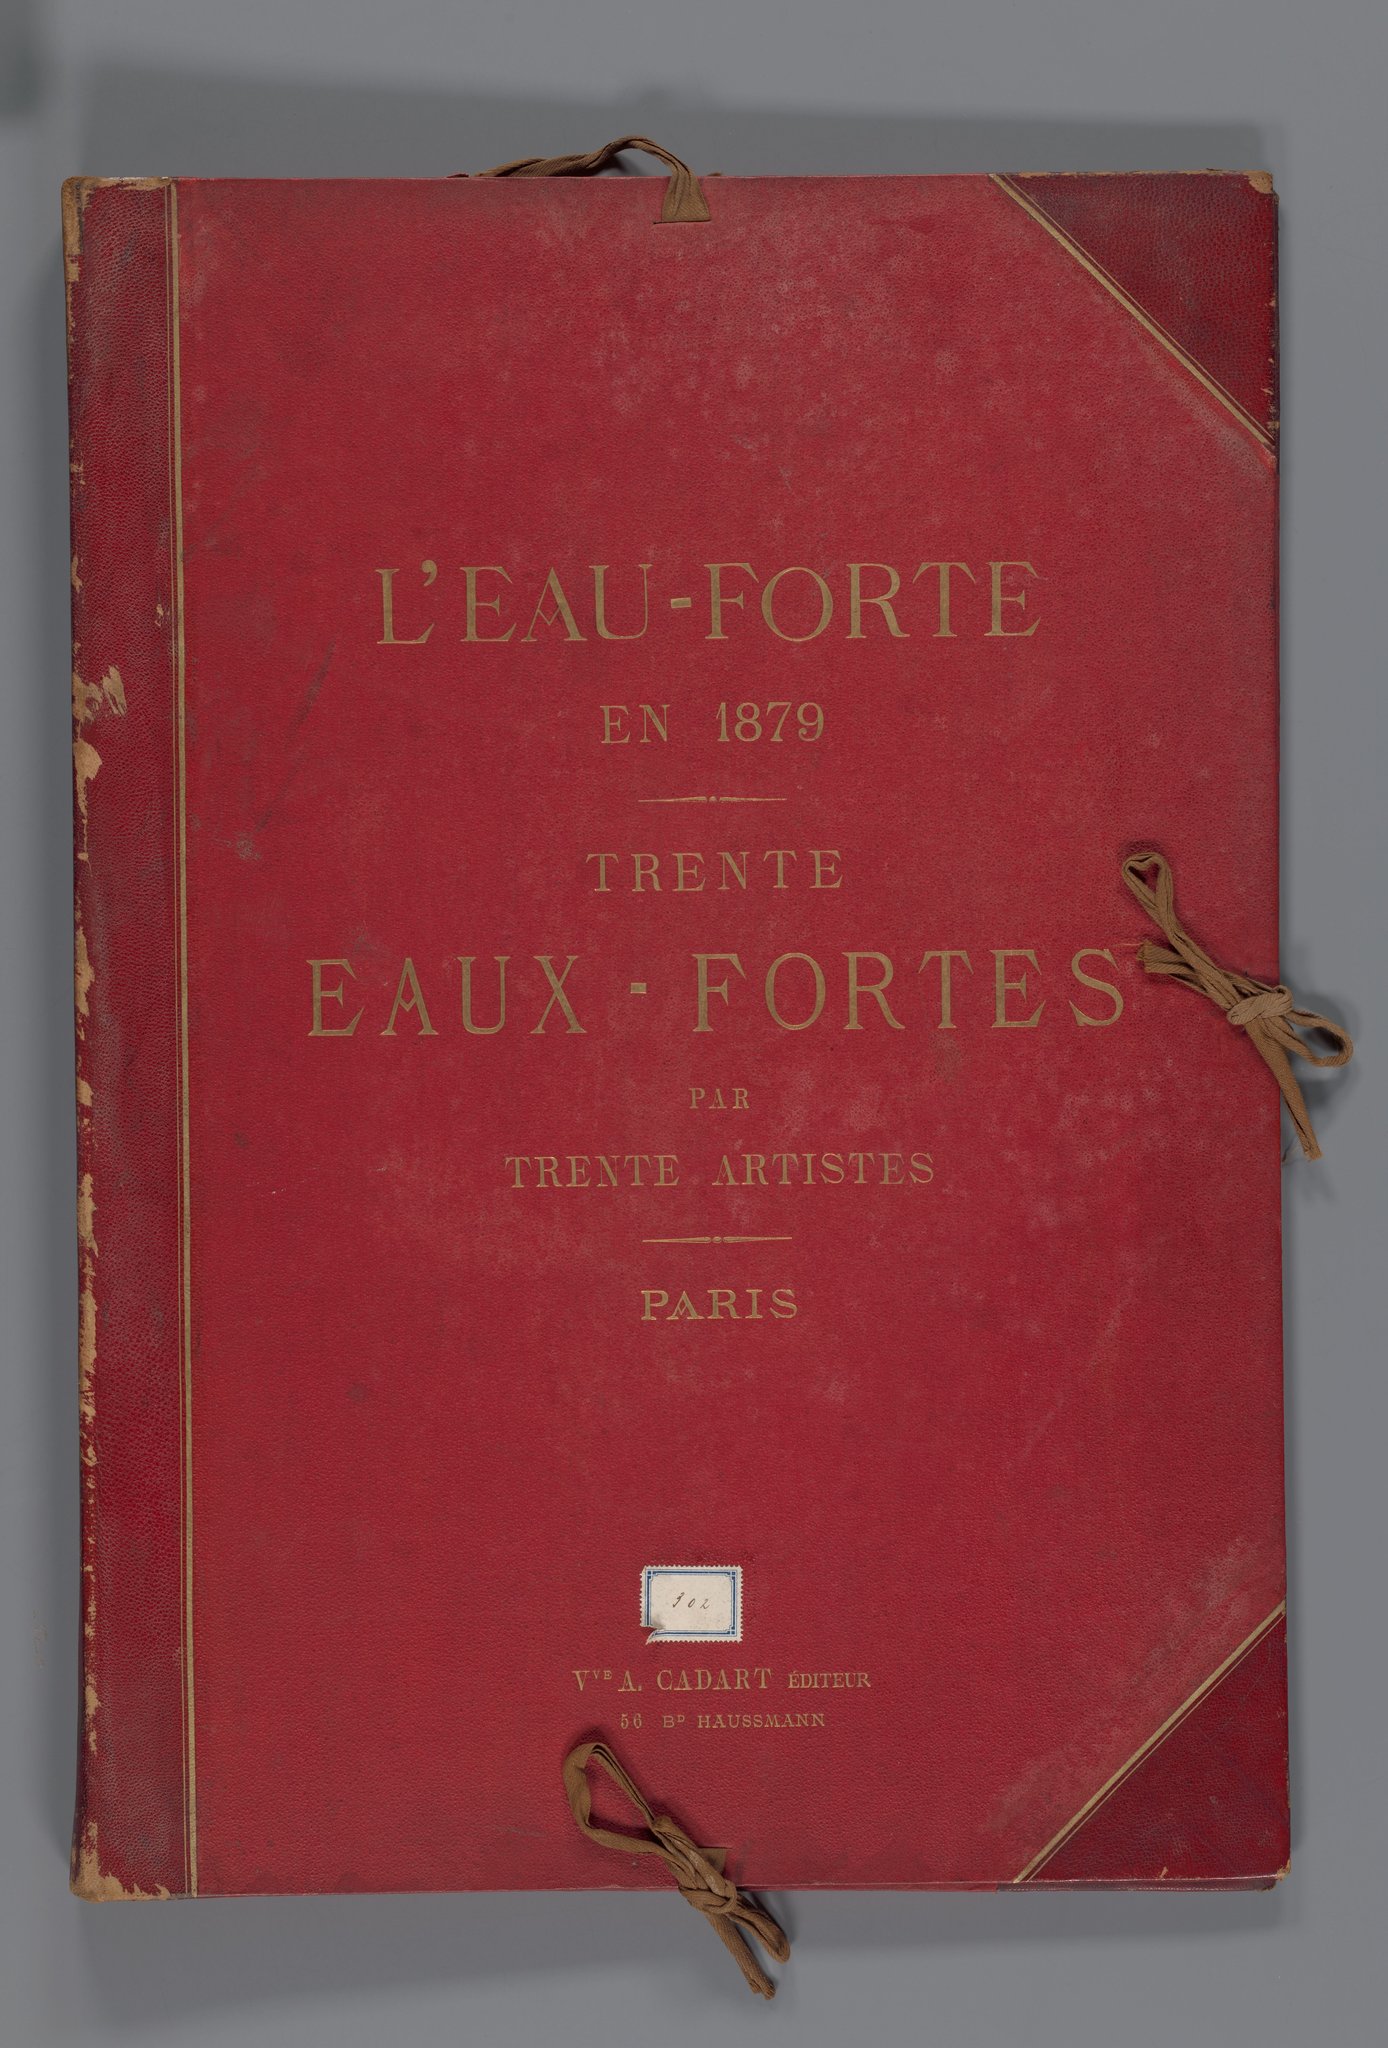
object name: wrapper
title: L'eau-forte en 1879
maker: weduwe alfred cadart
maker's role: printer, publisher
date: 1879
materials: cardboard, leather, linen, paper, ribbon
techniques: gold embossing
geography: paris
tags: city-view, and landscape with man-made constructions, landscapes, child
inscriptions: collector's mark: Lugt 2760, collector's mark: Lugt 2228, collector's mark: ‘AFE v S’, number: ‘302’